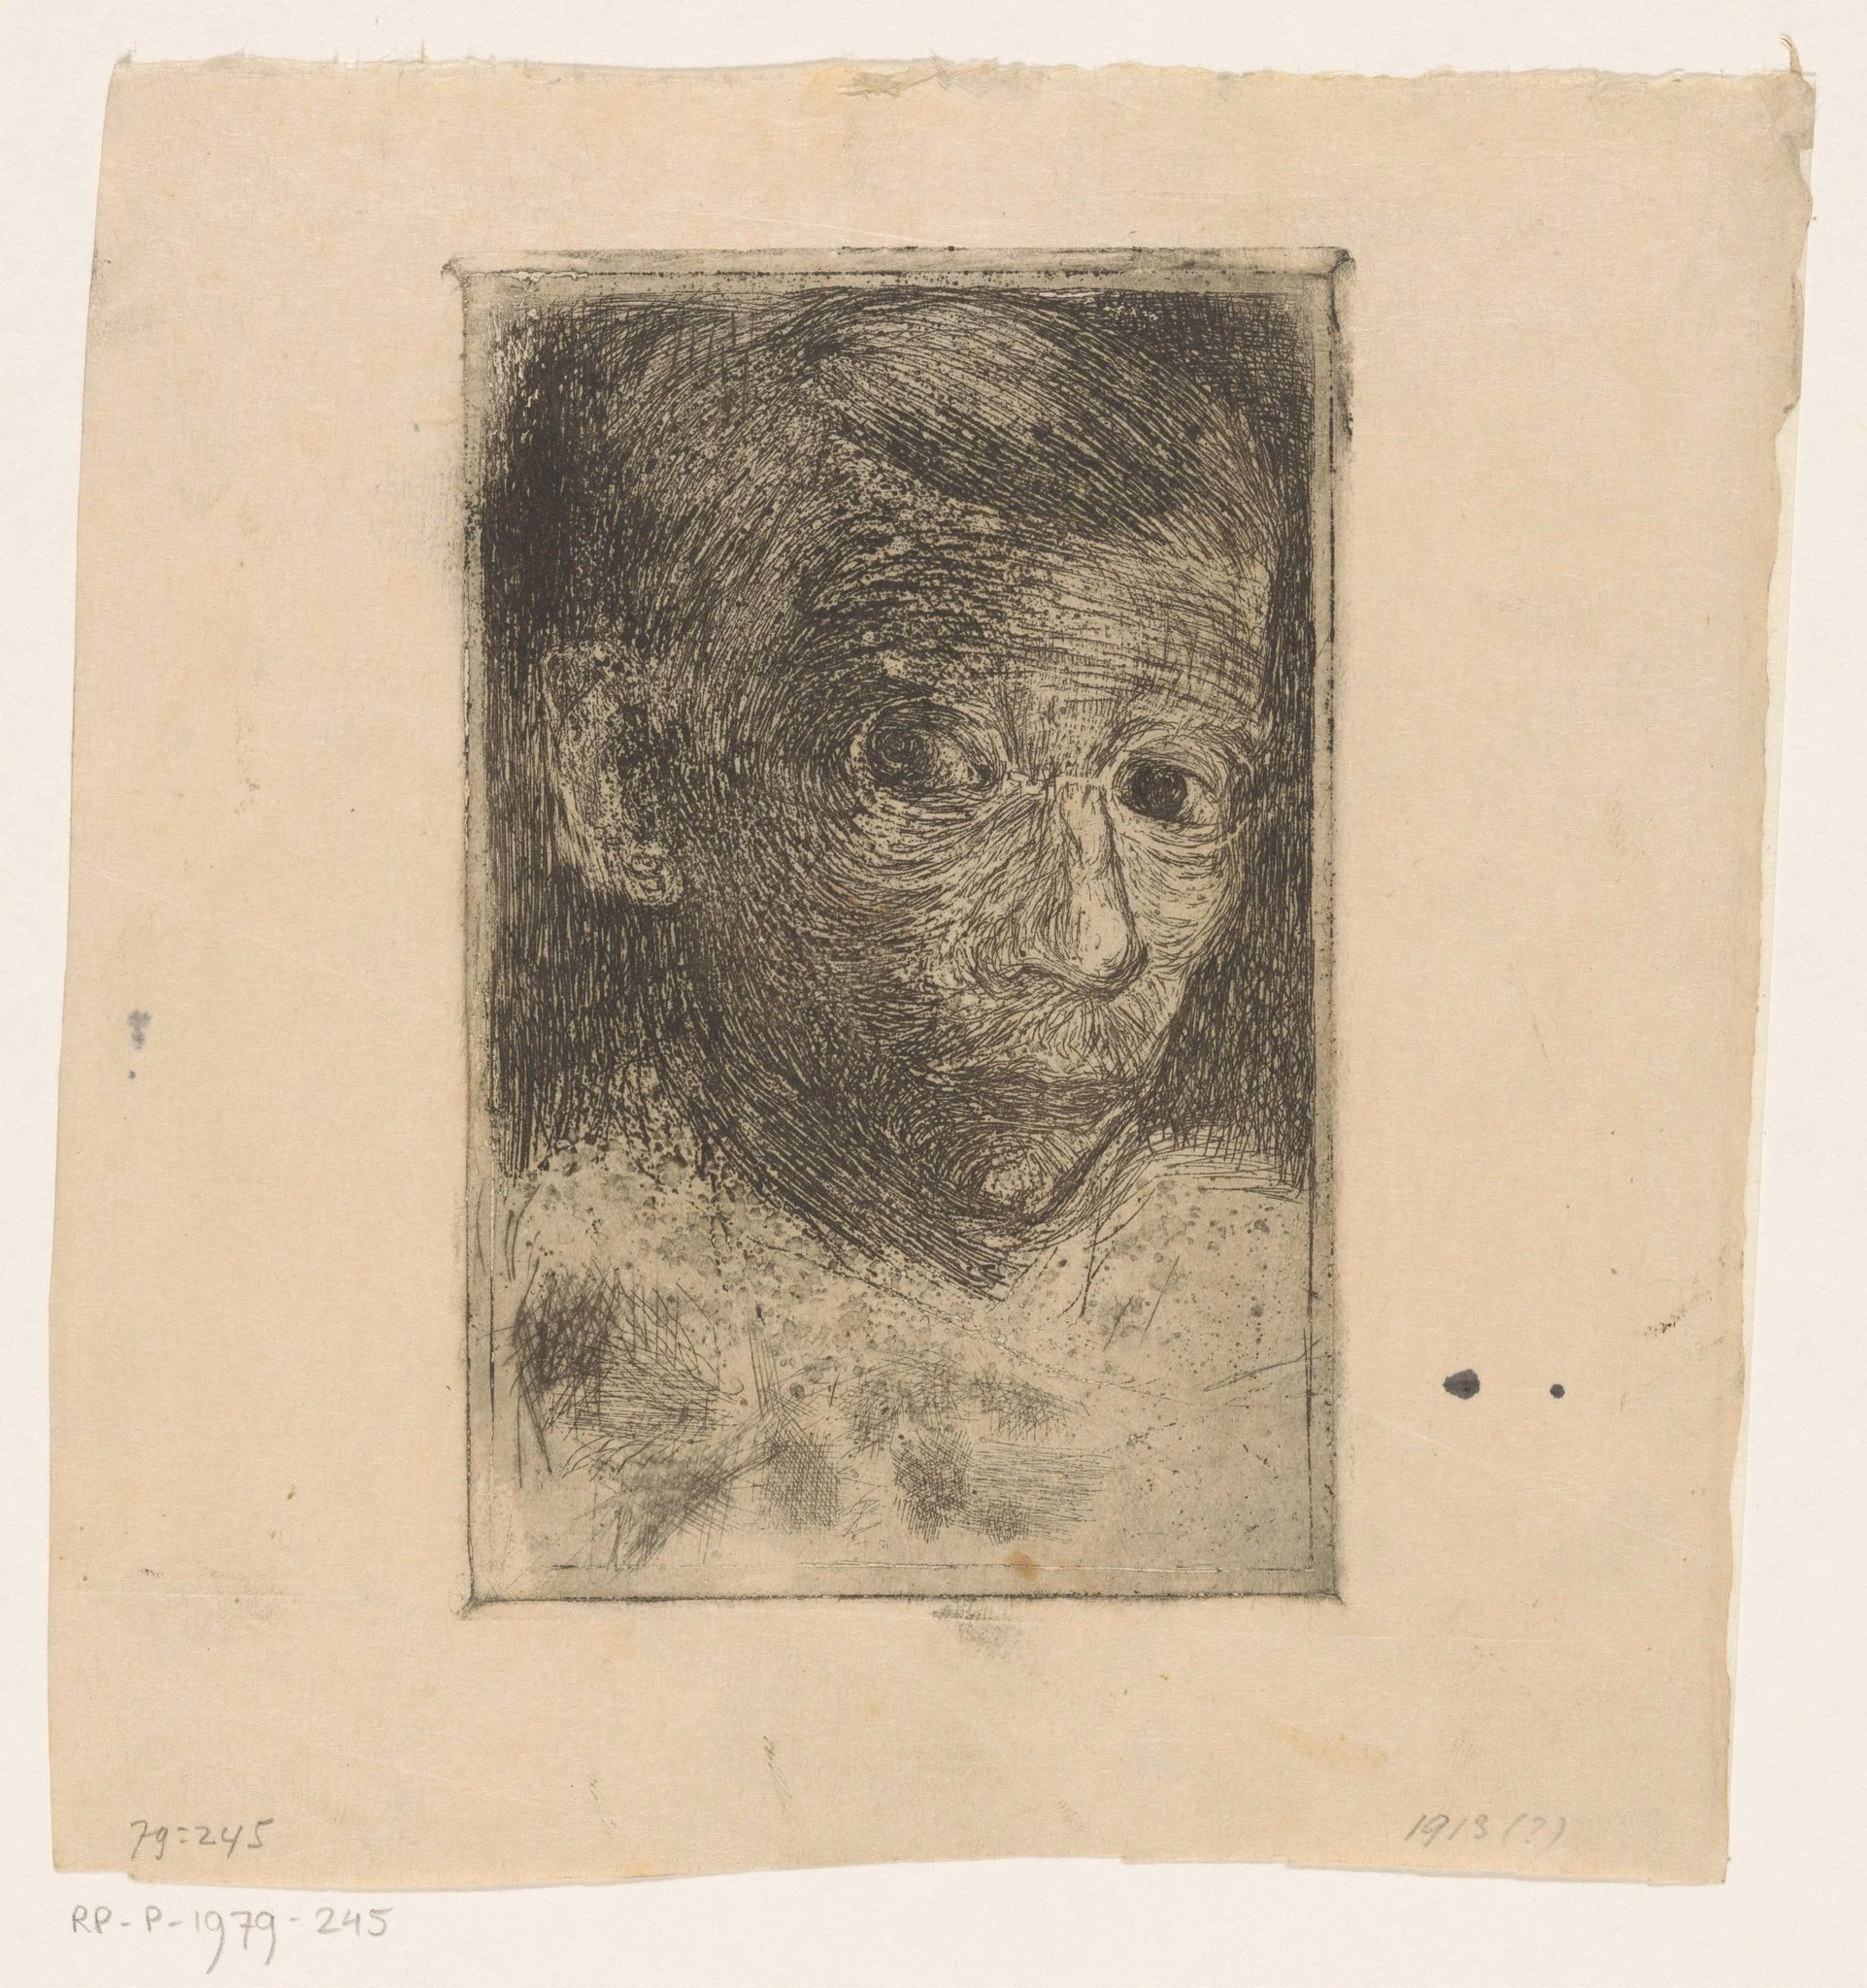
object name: print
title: Zelfportret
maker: jan mankes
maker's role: draughtsman, painter, print maker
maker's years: 1889-1920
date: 1915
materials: paper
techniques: etching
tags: draughtsman, jan mankes, portrait, self-portrait of artist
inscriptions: collector's mark: Lugt 2228